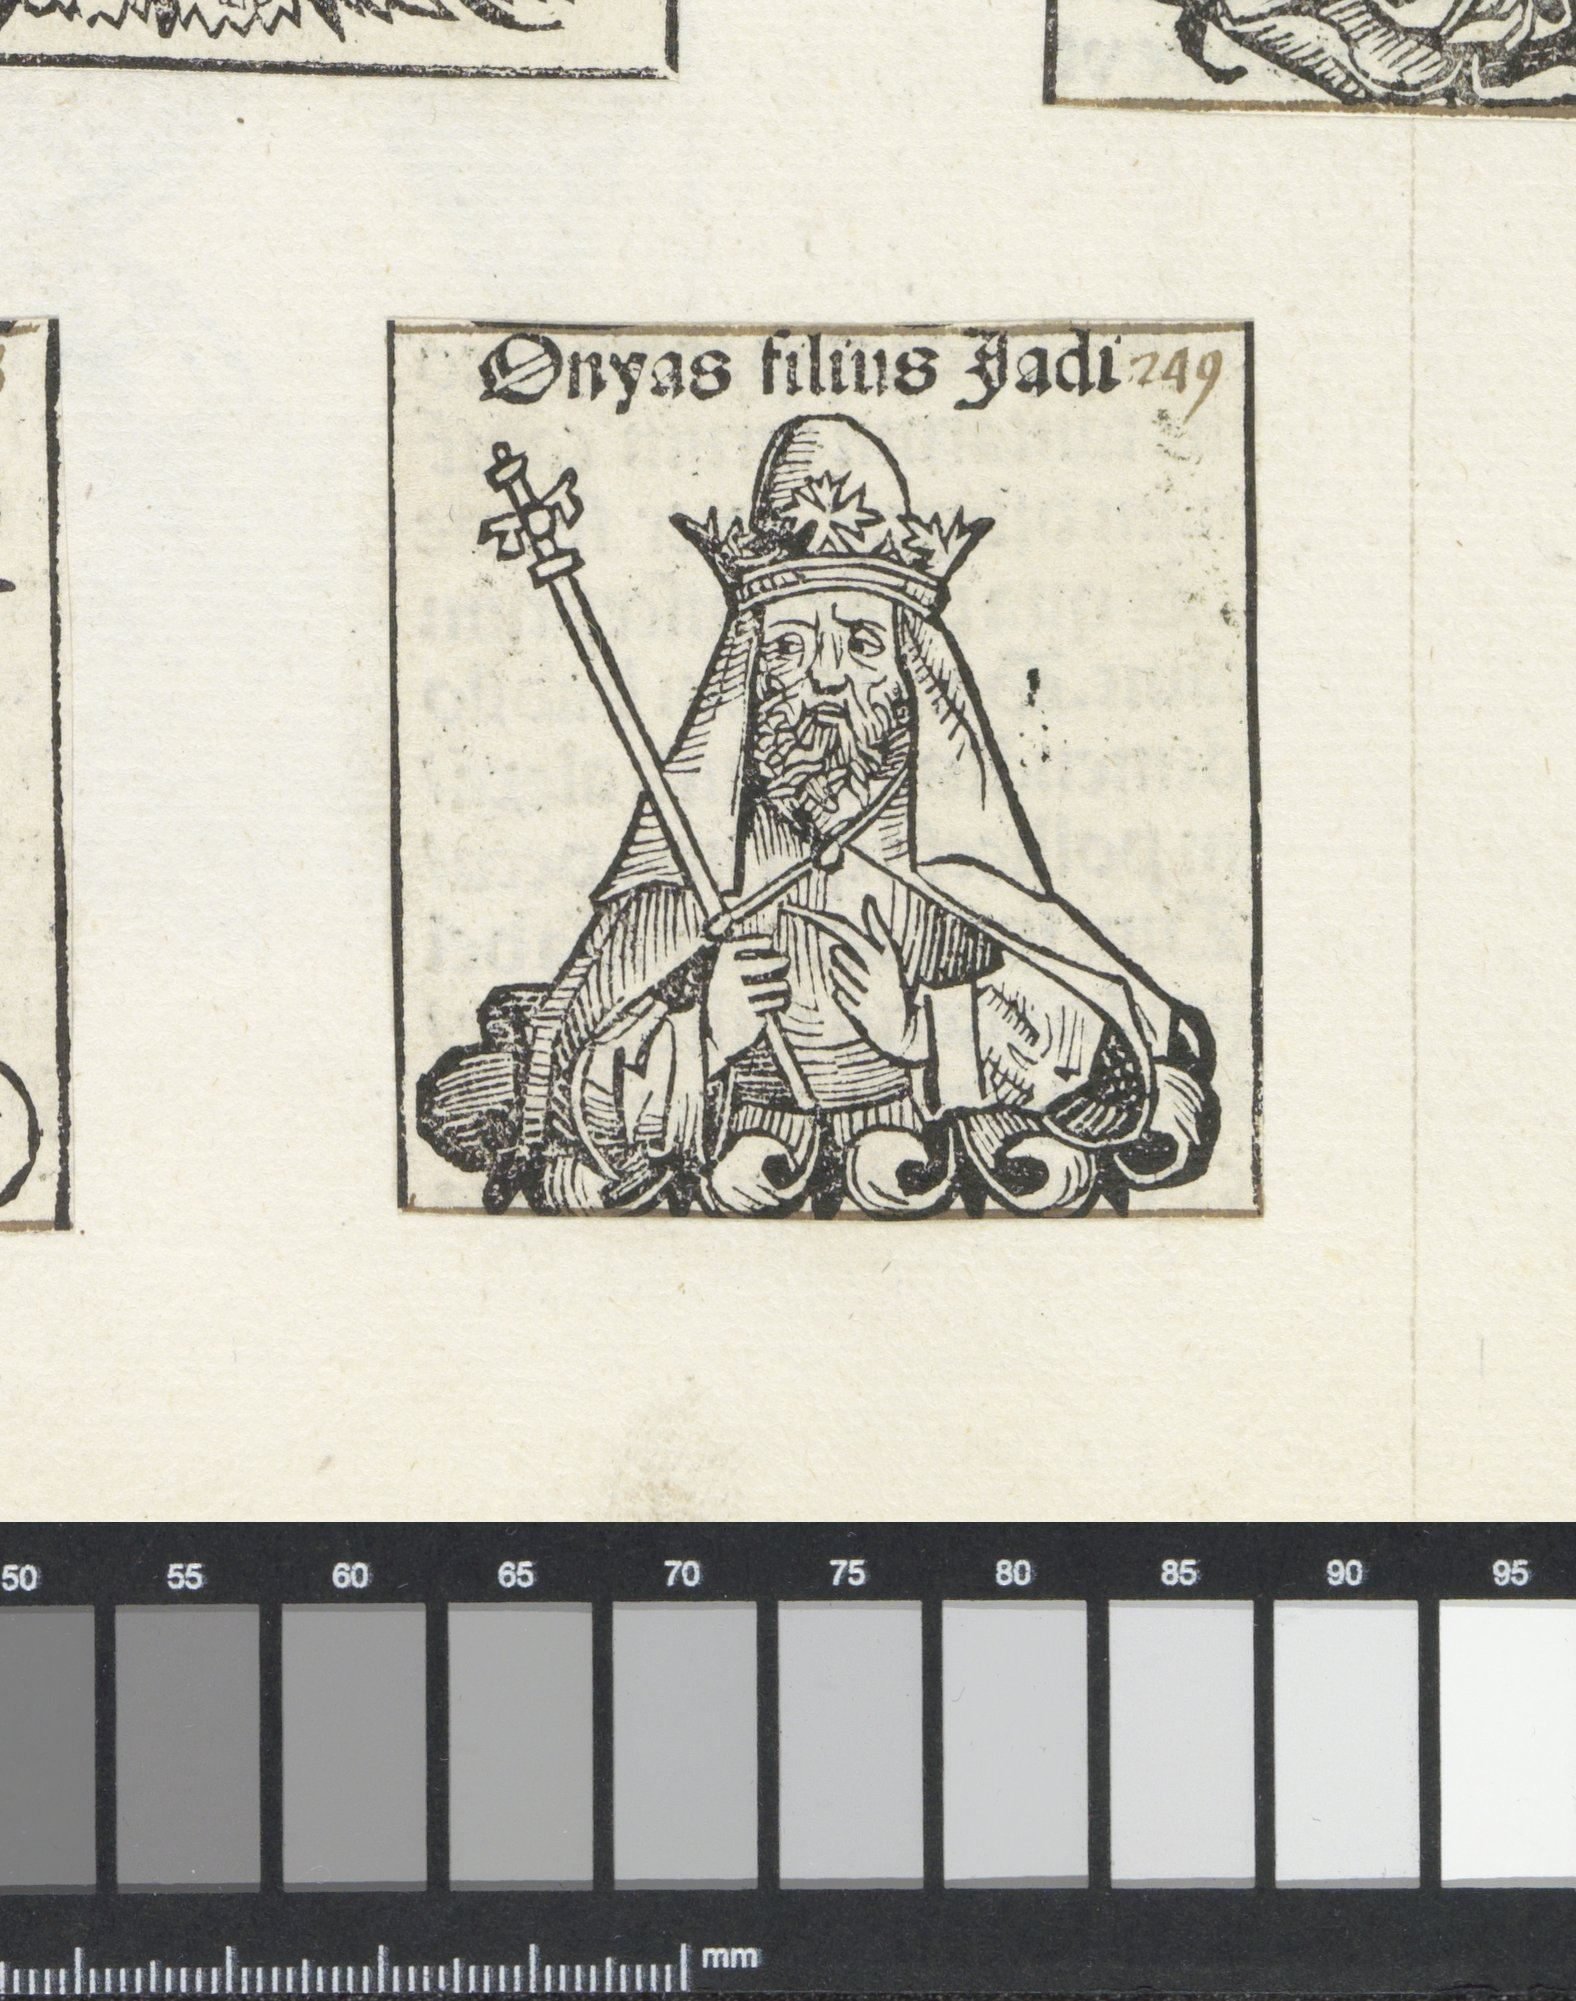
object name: album leaf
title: Onyas filius Jadi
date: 1493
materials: paper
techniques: letterpress printing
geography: nuremberg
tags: high priest ~ hierarchy of priests, persons from the old testament (not in biblical context, nor occurring in legendary/historical extensions included in division 71)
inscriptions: inscription: ‘249’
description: Een bloemkelk met een man in priesterkledij en met kroon en scepter, naar voren gericht. De tekst identificeert hem als de hogepriester Onias I, de zoon van Jadus. De voorstelling is onderdeel van de opeenvolging priesters in de Liber Chronicarum. De prent maakt deel uit van een album.